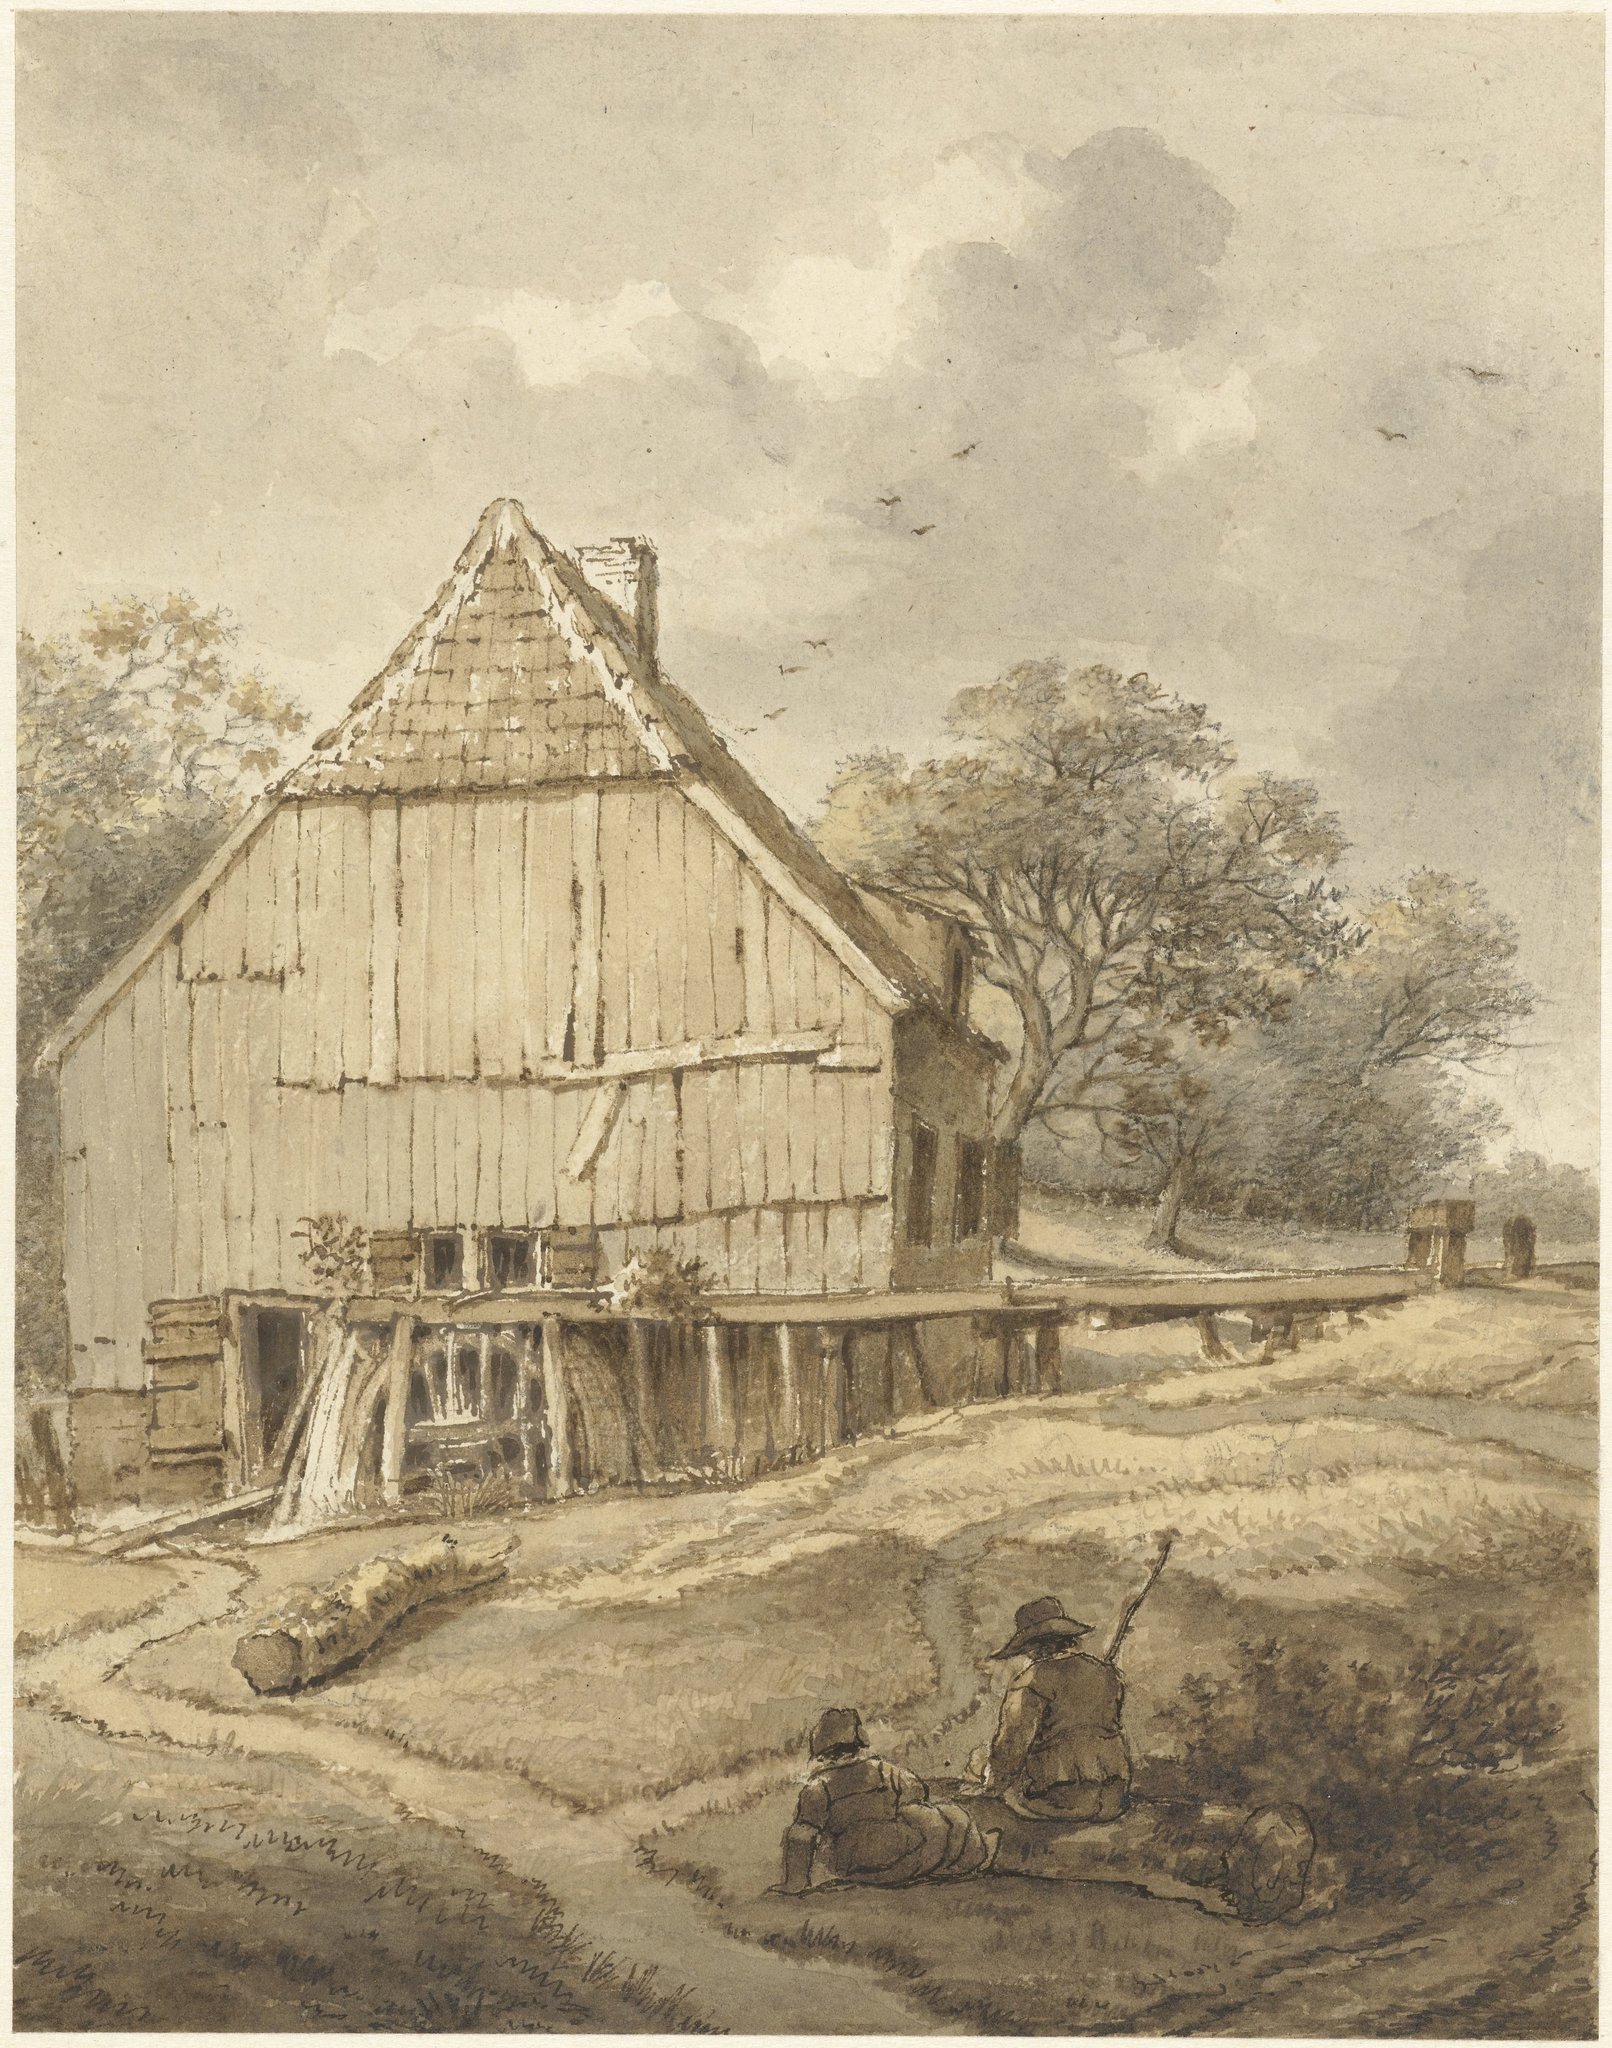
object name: drawing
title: Gezicht aan de Klingelbeek bij Arnhem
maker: daniël kerkhoff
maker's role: draughtsman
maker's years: 1766-1821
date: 1809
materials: chalk, ink, paper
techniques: brush, pen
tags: watermill, arnhem